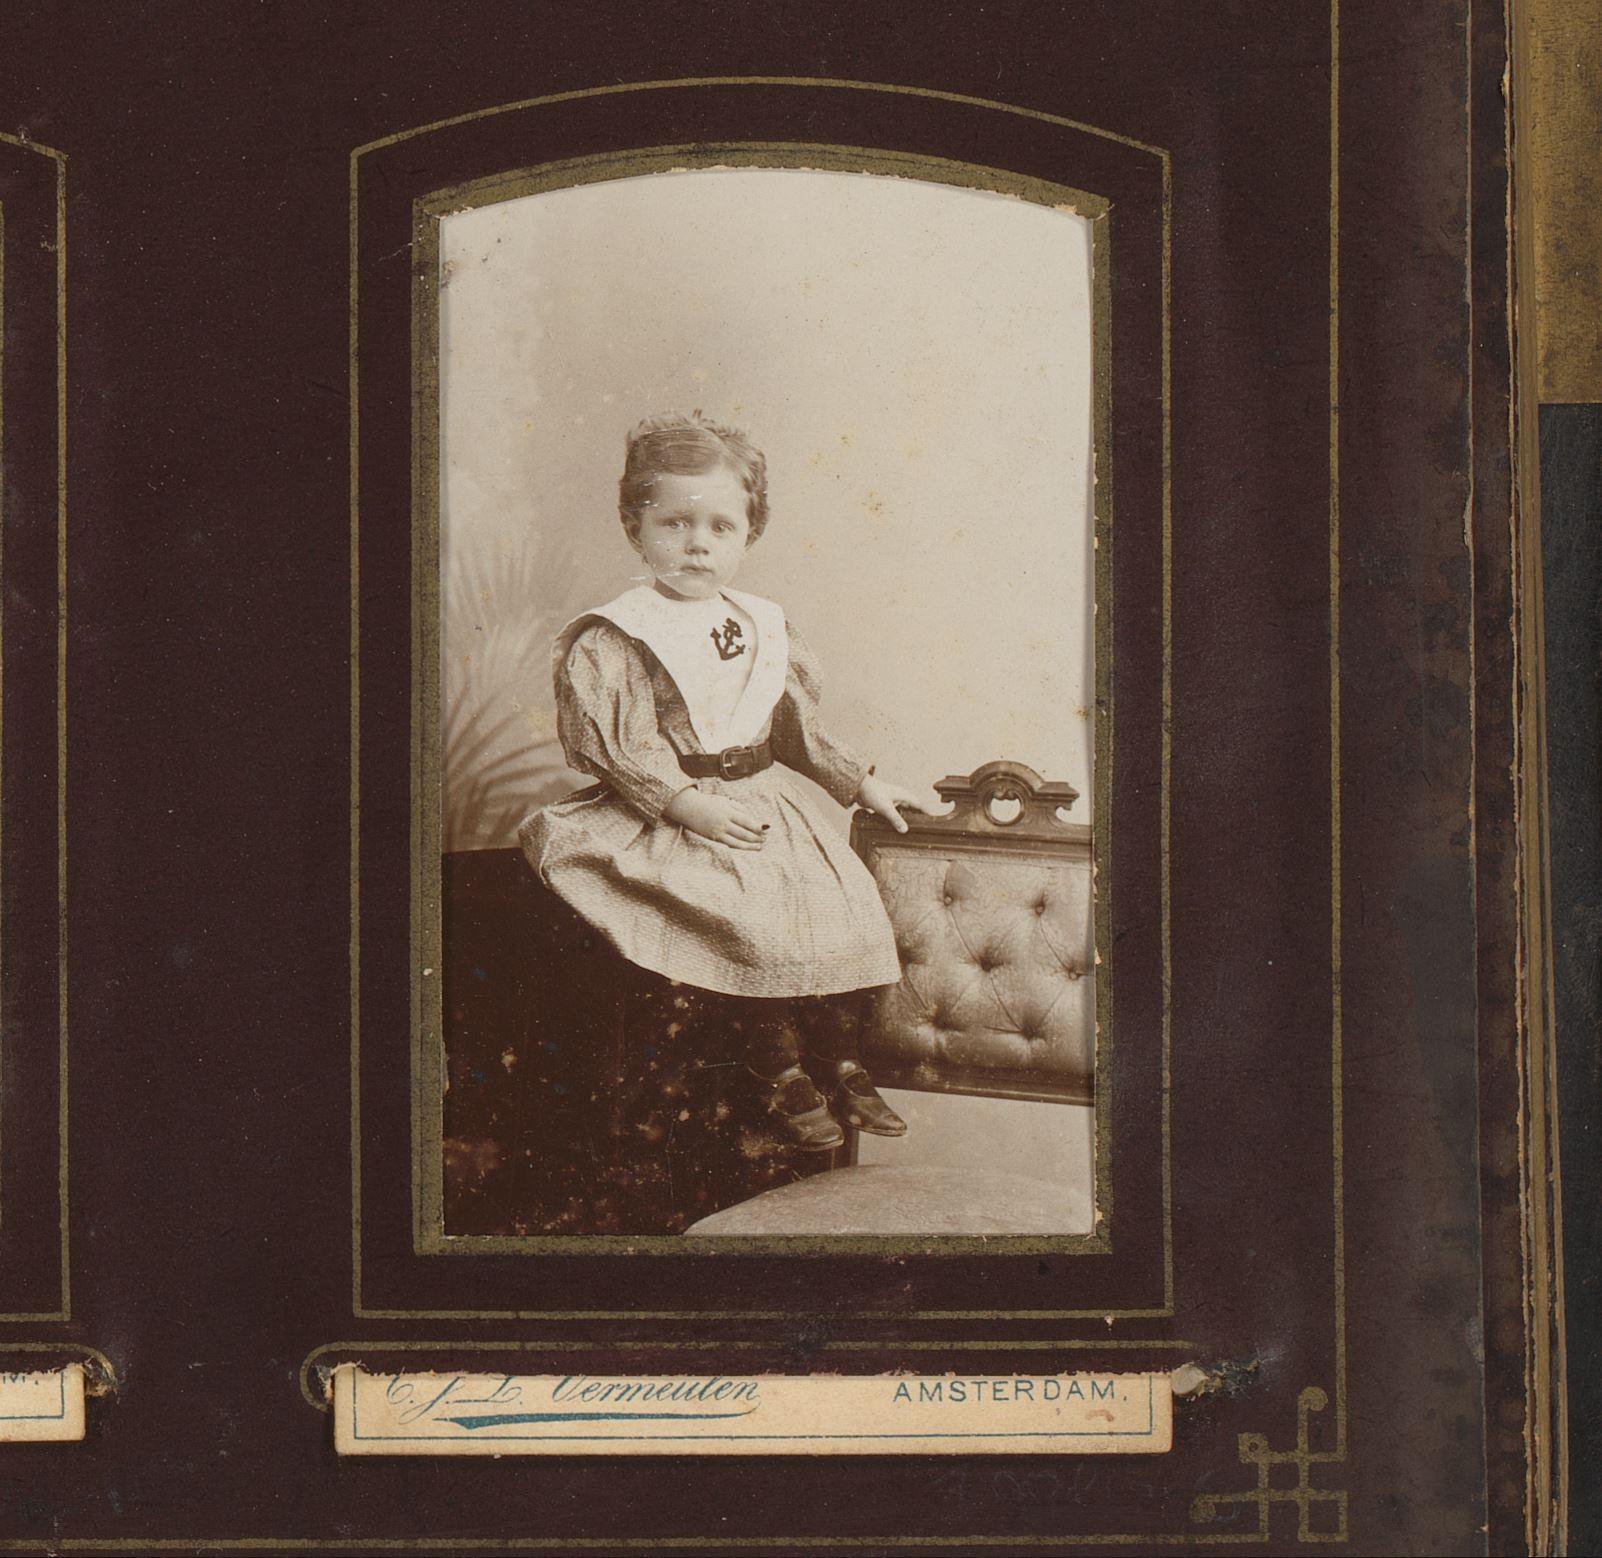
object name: photograph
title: Portret van een zittend meisje in jurk met matrozenkraag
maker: cornelis johannes lodewicus vermeulen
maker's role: fotograaf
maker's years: 1861-1936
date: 1878-1896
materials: cardboard, photographic support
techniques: collodion silver print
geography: amsterdam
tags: historical persons - bb - woman, toddler (female), chair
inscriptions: inscription: ‘C.J.L. Vermeulen/ Amsterdam/ Heerenstraat 6./ Heiligenweg hoek Singel./ Specialiteit in vergrootingen’